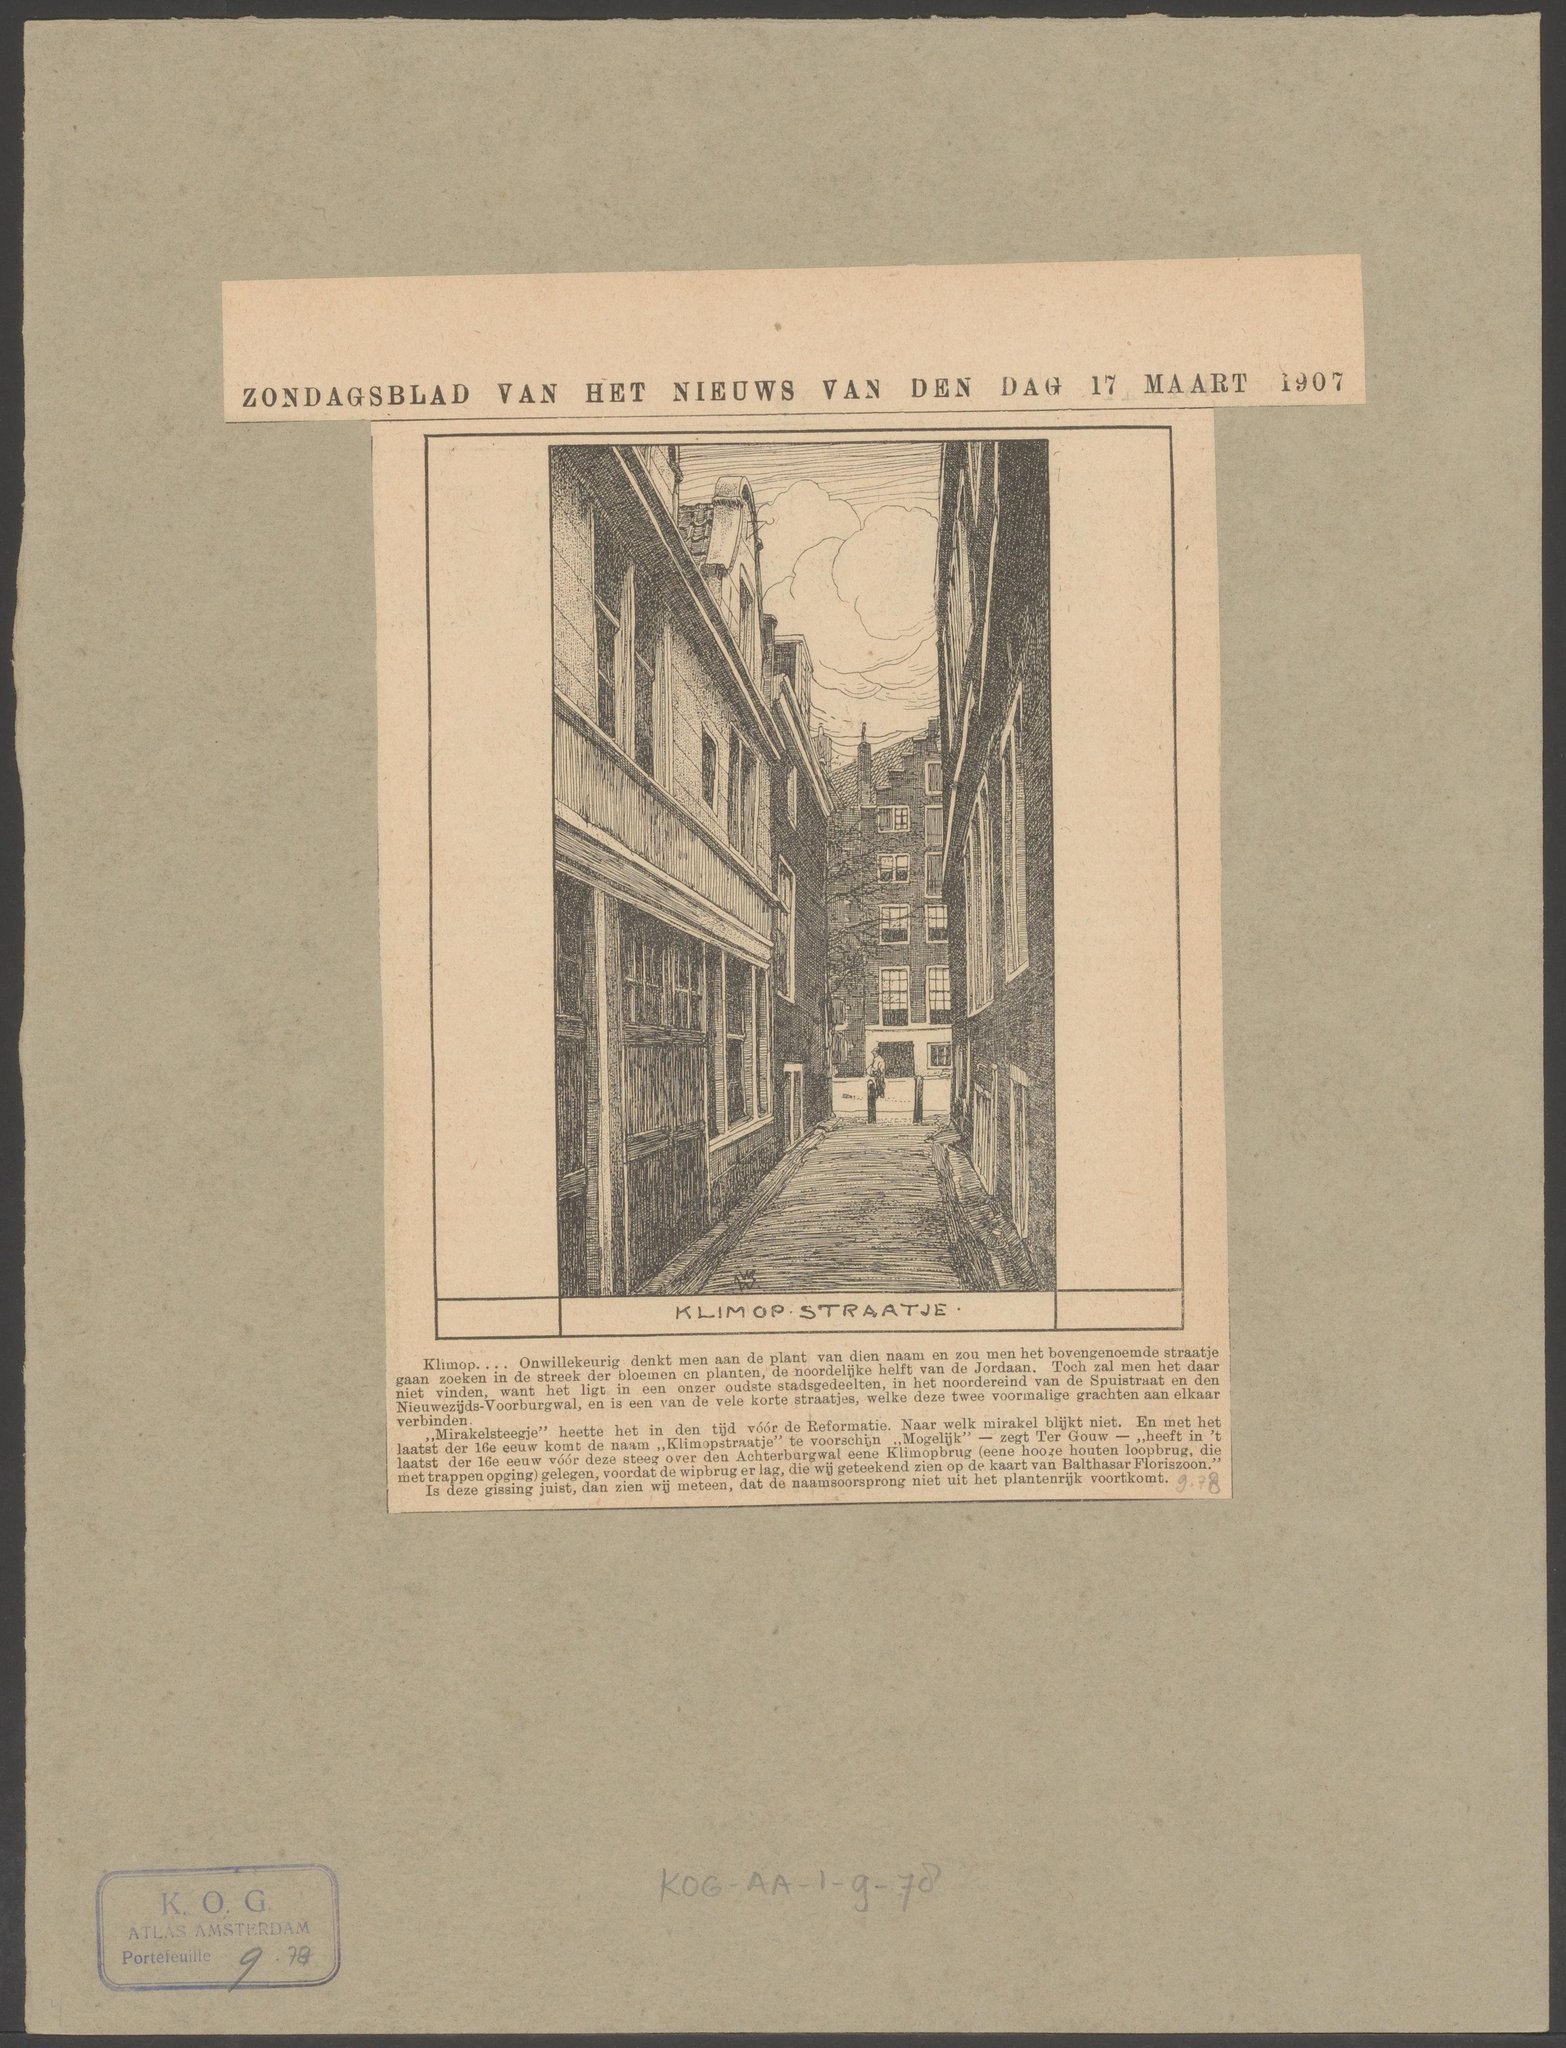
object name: photomechanical print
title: Gezicht op de Klimopstraat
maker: willem wenckebach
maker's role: designer, draughtsman, painter, print maker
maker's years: 1860-1937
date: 1907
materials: paper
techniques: letterpress printing, line block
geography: amsterdam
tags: city-view in general; 'veduta', the usual house or row of houses, lane, alley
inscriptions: collector's mark: ‘9-78’ Lugt 1641b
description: Onderwerpsrubriek binnen de Atlas Amsterdam: Kadijksplein, Karthuizerkerkhof, Kattegat, Kattenburg, Kapelsteeg O.Z., Enge Kerksteeg, Kerkstraat, Kinkerstraat, Kolk O.Z., Koningsplein, Kromboomsloot [Krom Boomssloot], Kostverlorenkade, Kwakersdwarspad, Kalverstraat, Keizersgracht (v.d. Brouwersgracht – Amstel), Klerensloot (Gedempte), Klimopstraat, Kloveniersburgwal, Kraansluis.